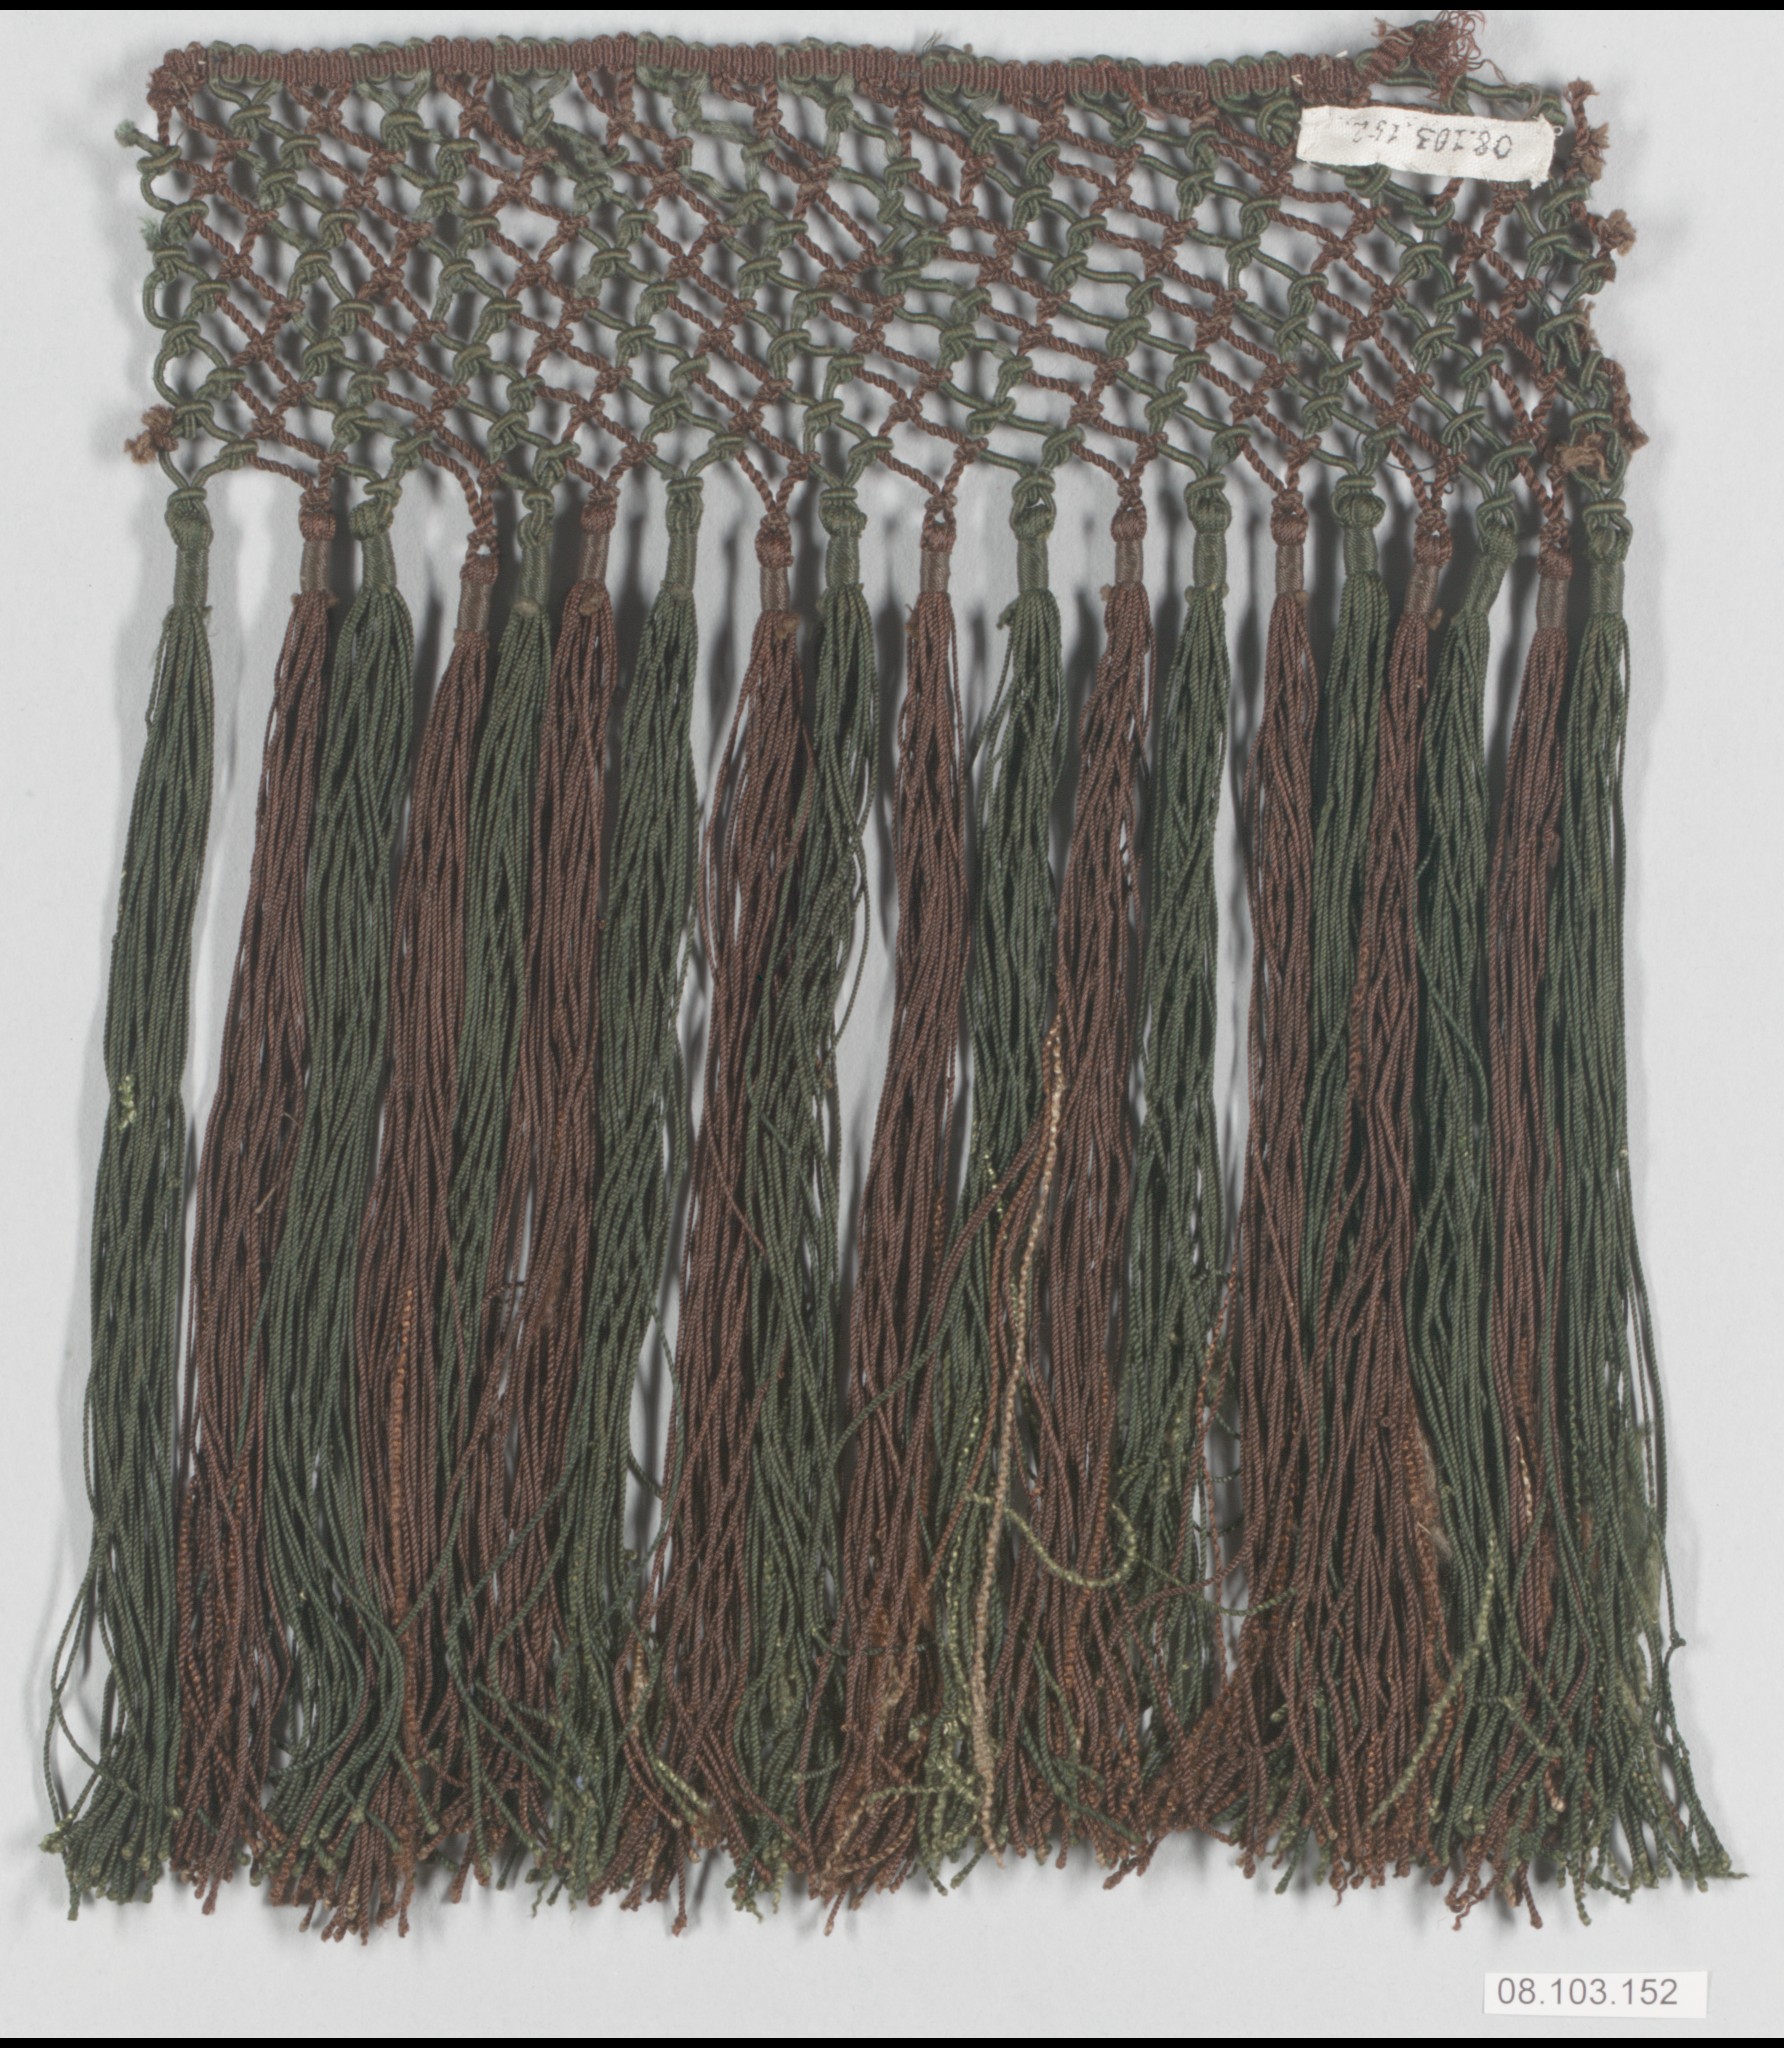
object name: fringe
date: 1801-1900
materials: silk